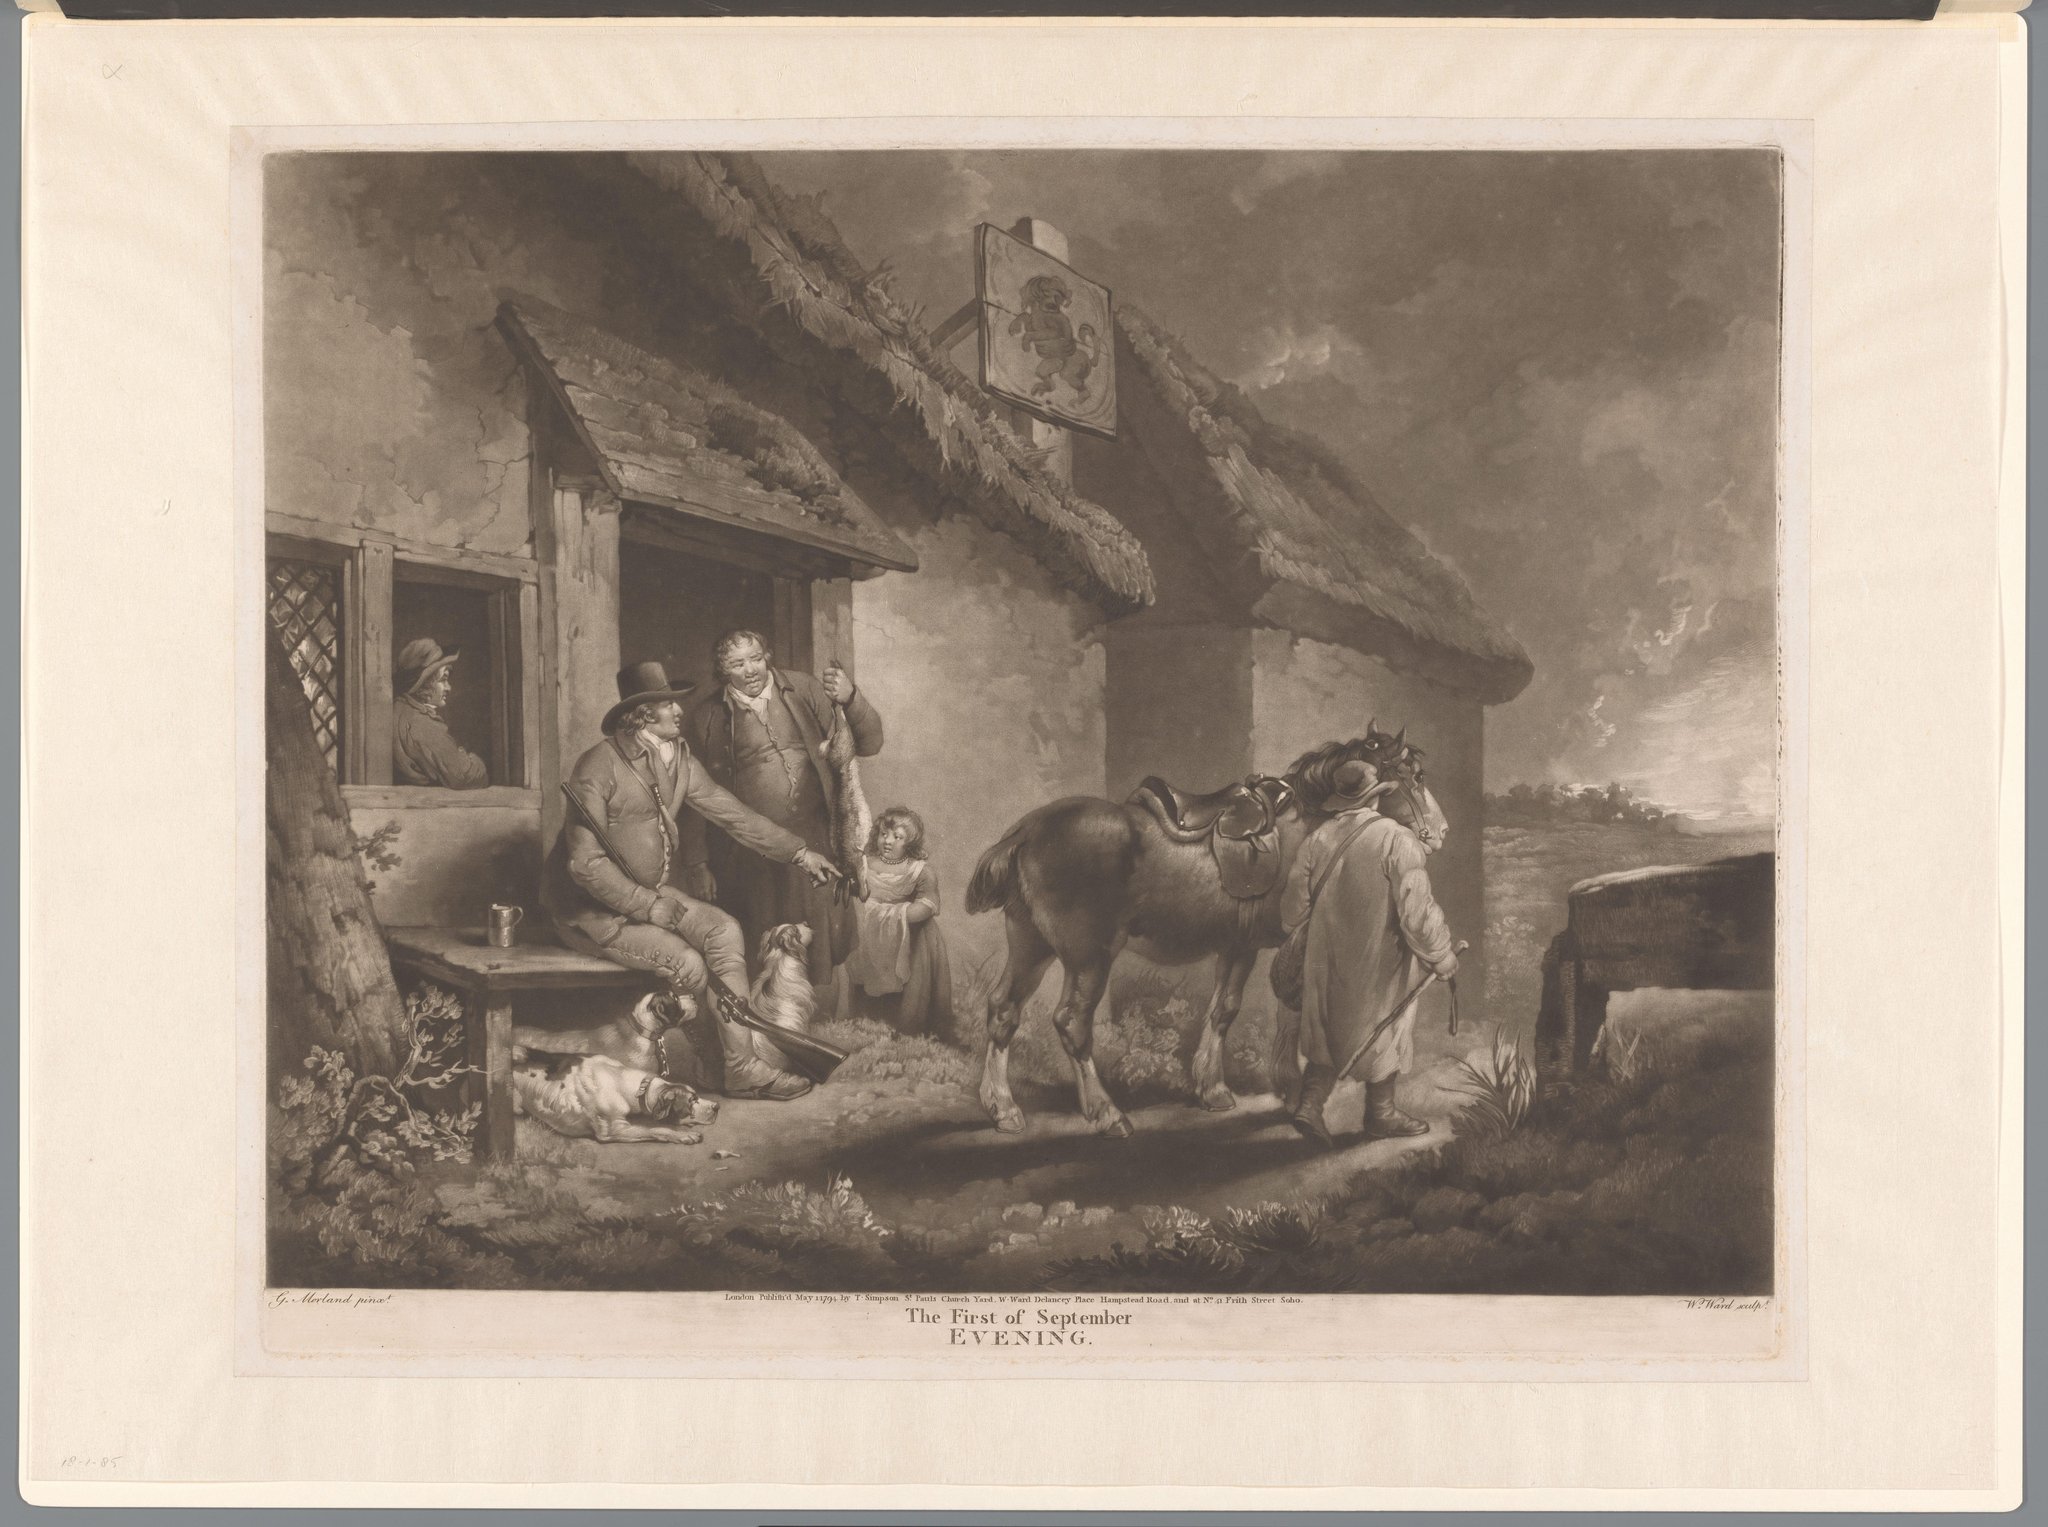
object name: print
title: Jagers en jachthonden met hun buit bij een herberg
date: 1794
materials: paper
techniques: drypoint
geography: london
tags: game, hunted animals, arrival and return ~ travelling, hotel, hostelry, inn, hunting-seat, hunting lodge, 'rendez-vous de chasse', 'jagdschloss'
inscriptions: number: ‘N. 172’, collector's mark: Lugt 2228